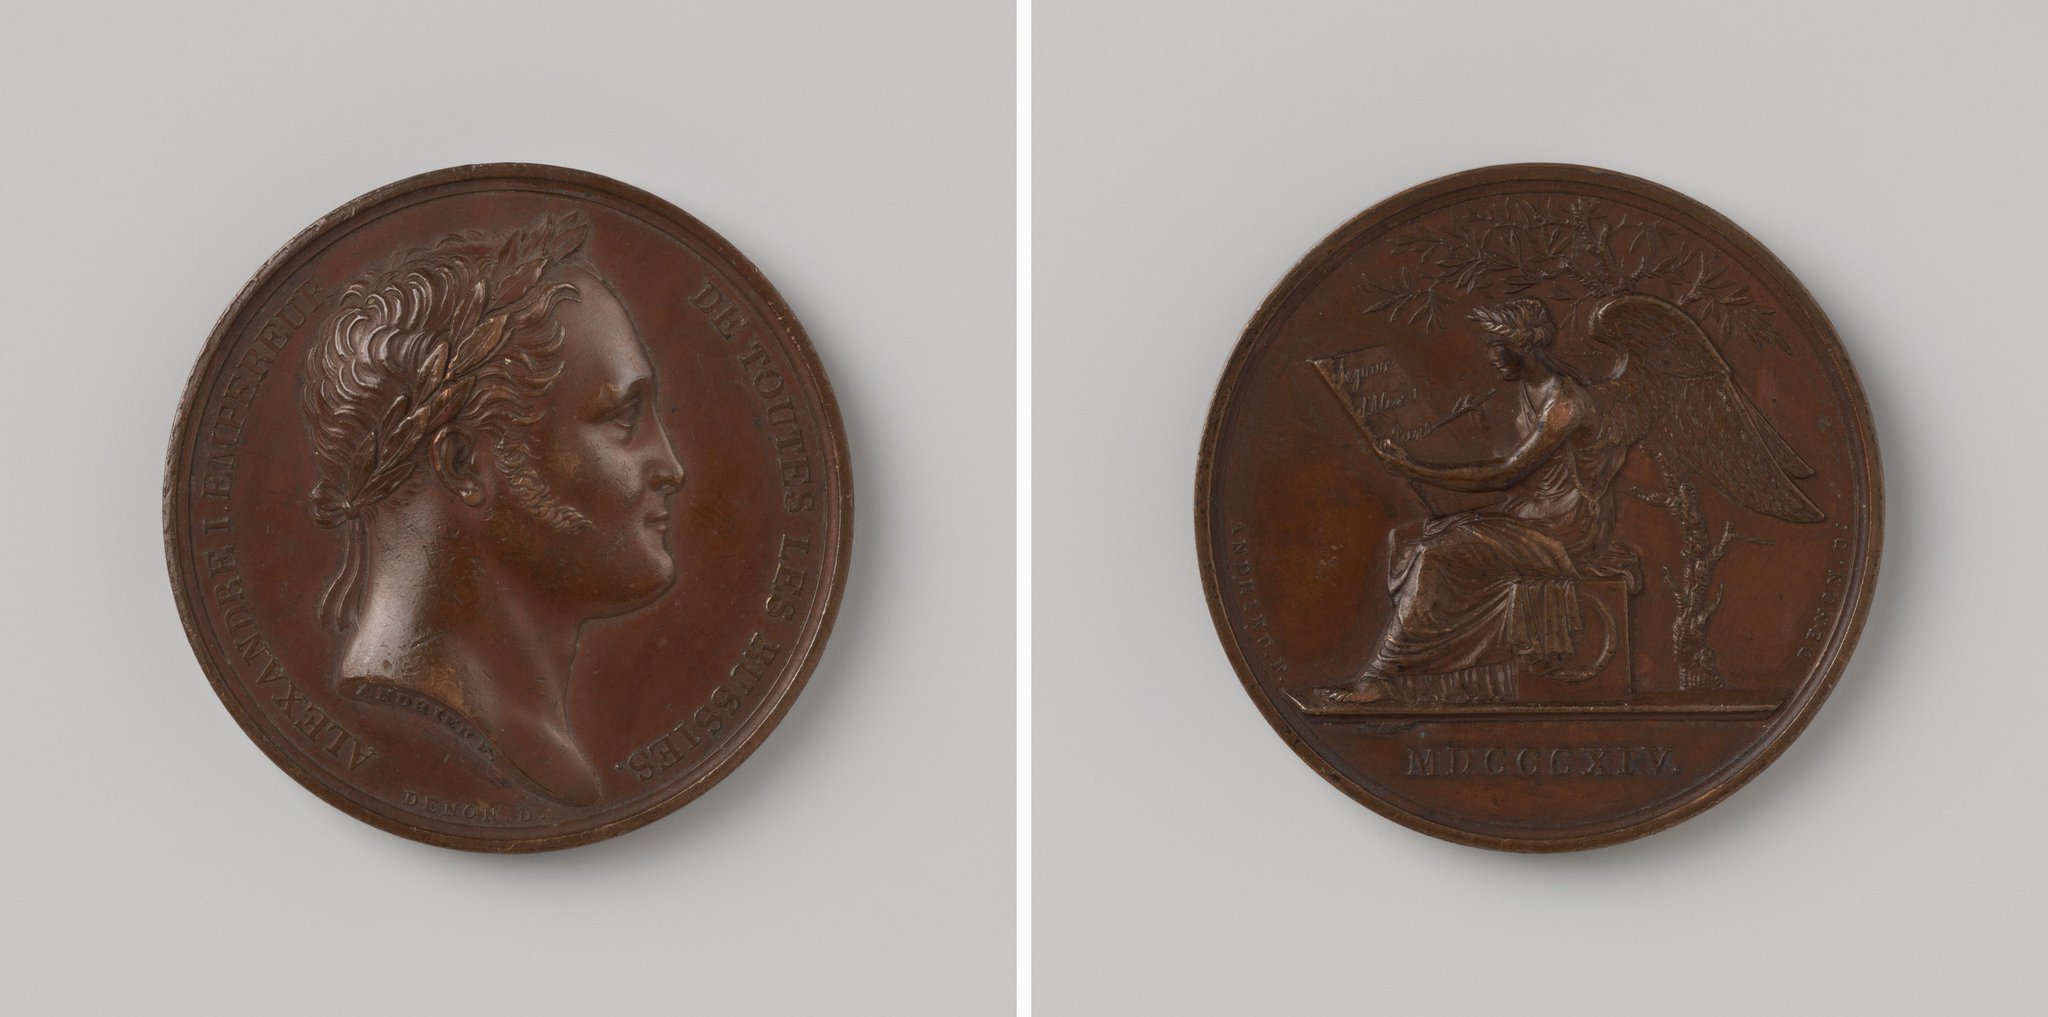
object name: history medal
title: Verblijf van Alexander I, tsaar van Rusland aan te Parijs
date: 1814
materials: bronze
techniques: striking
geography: paris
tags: alexander i (tsaar van rusland), paris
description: Bronzen penning. Voorzijde: borststuk man met lauwerkrans binnen omschrift. Keerzijde: gevleugelde Overwinning, zittend onder boom schrijft op stuk papier; afsnede: jaartal